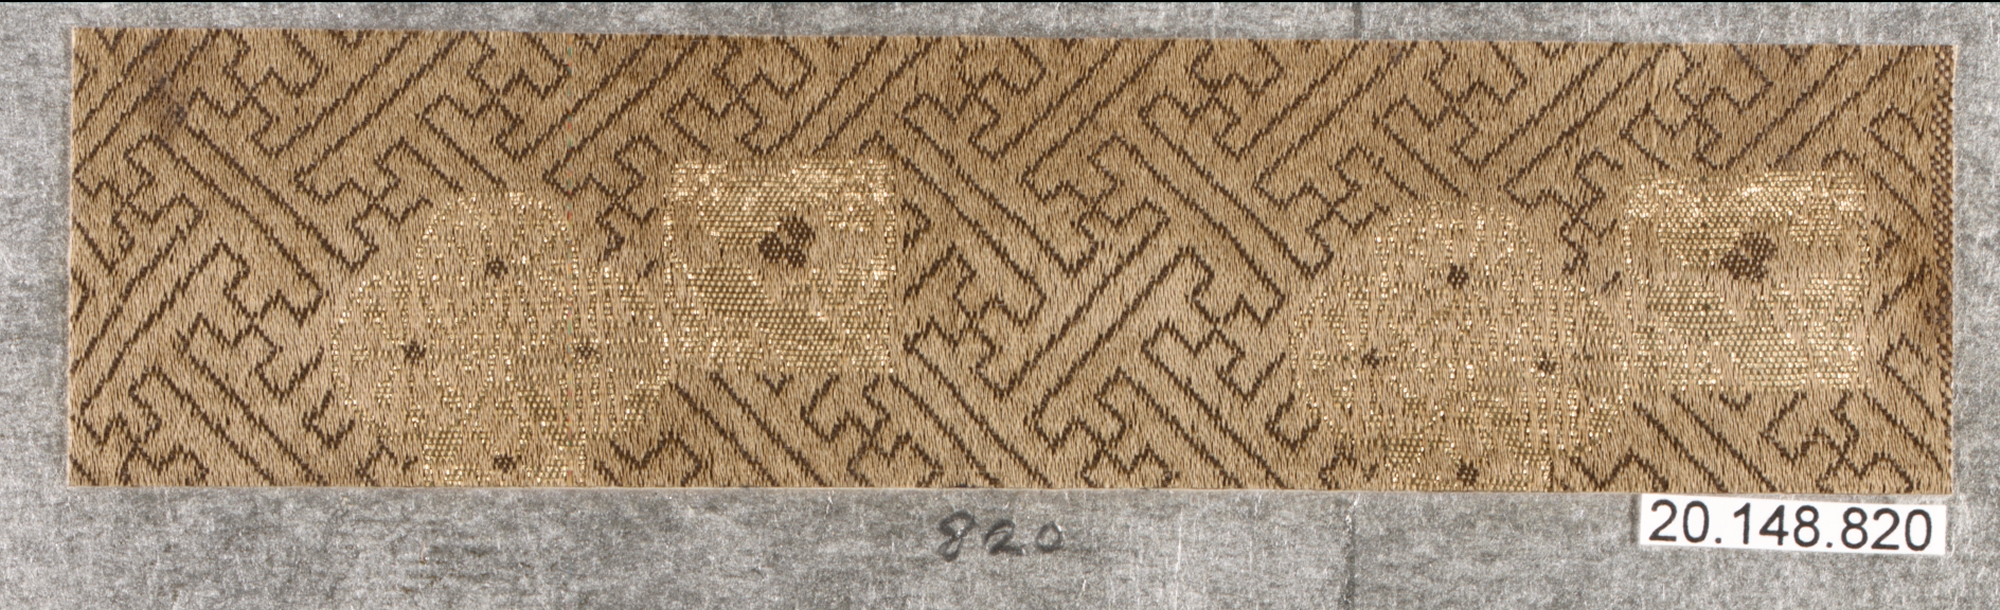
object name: piece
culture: japanese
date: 1701-1800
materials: silk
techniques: compound weave